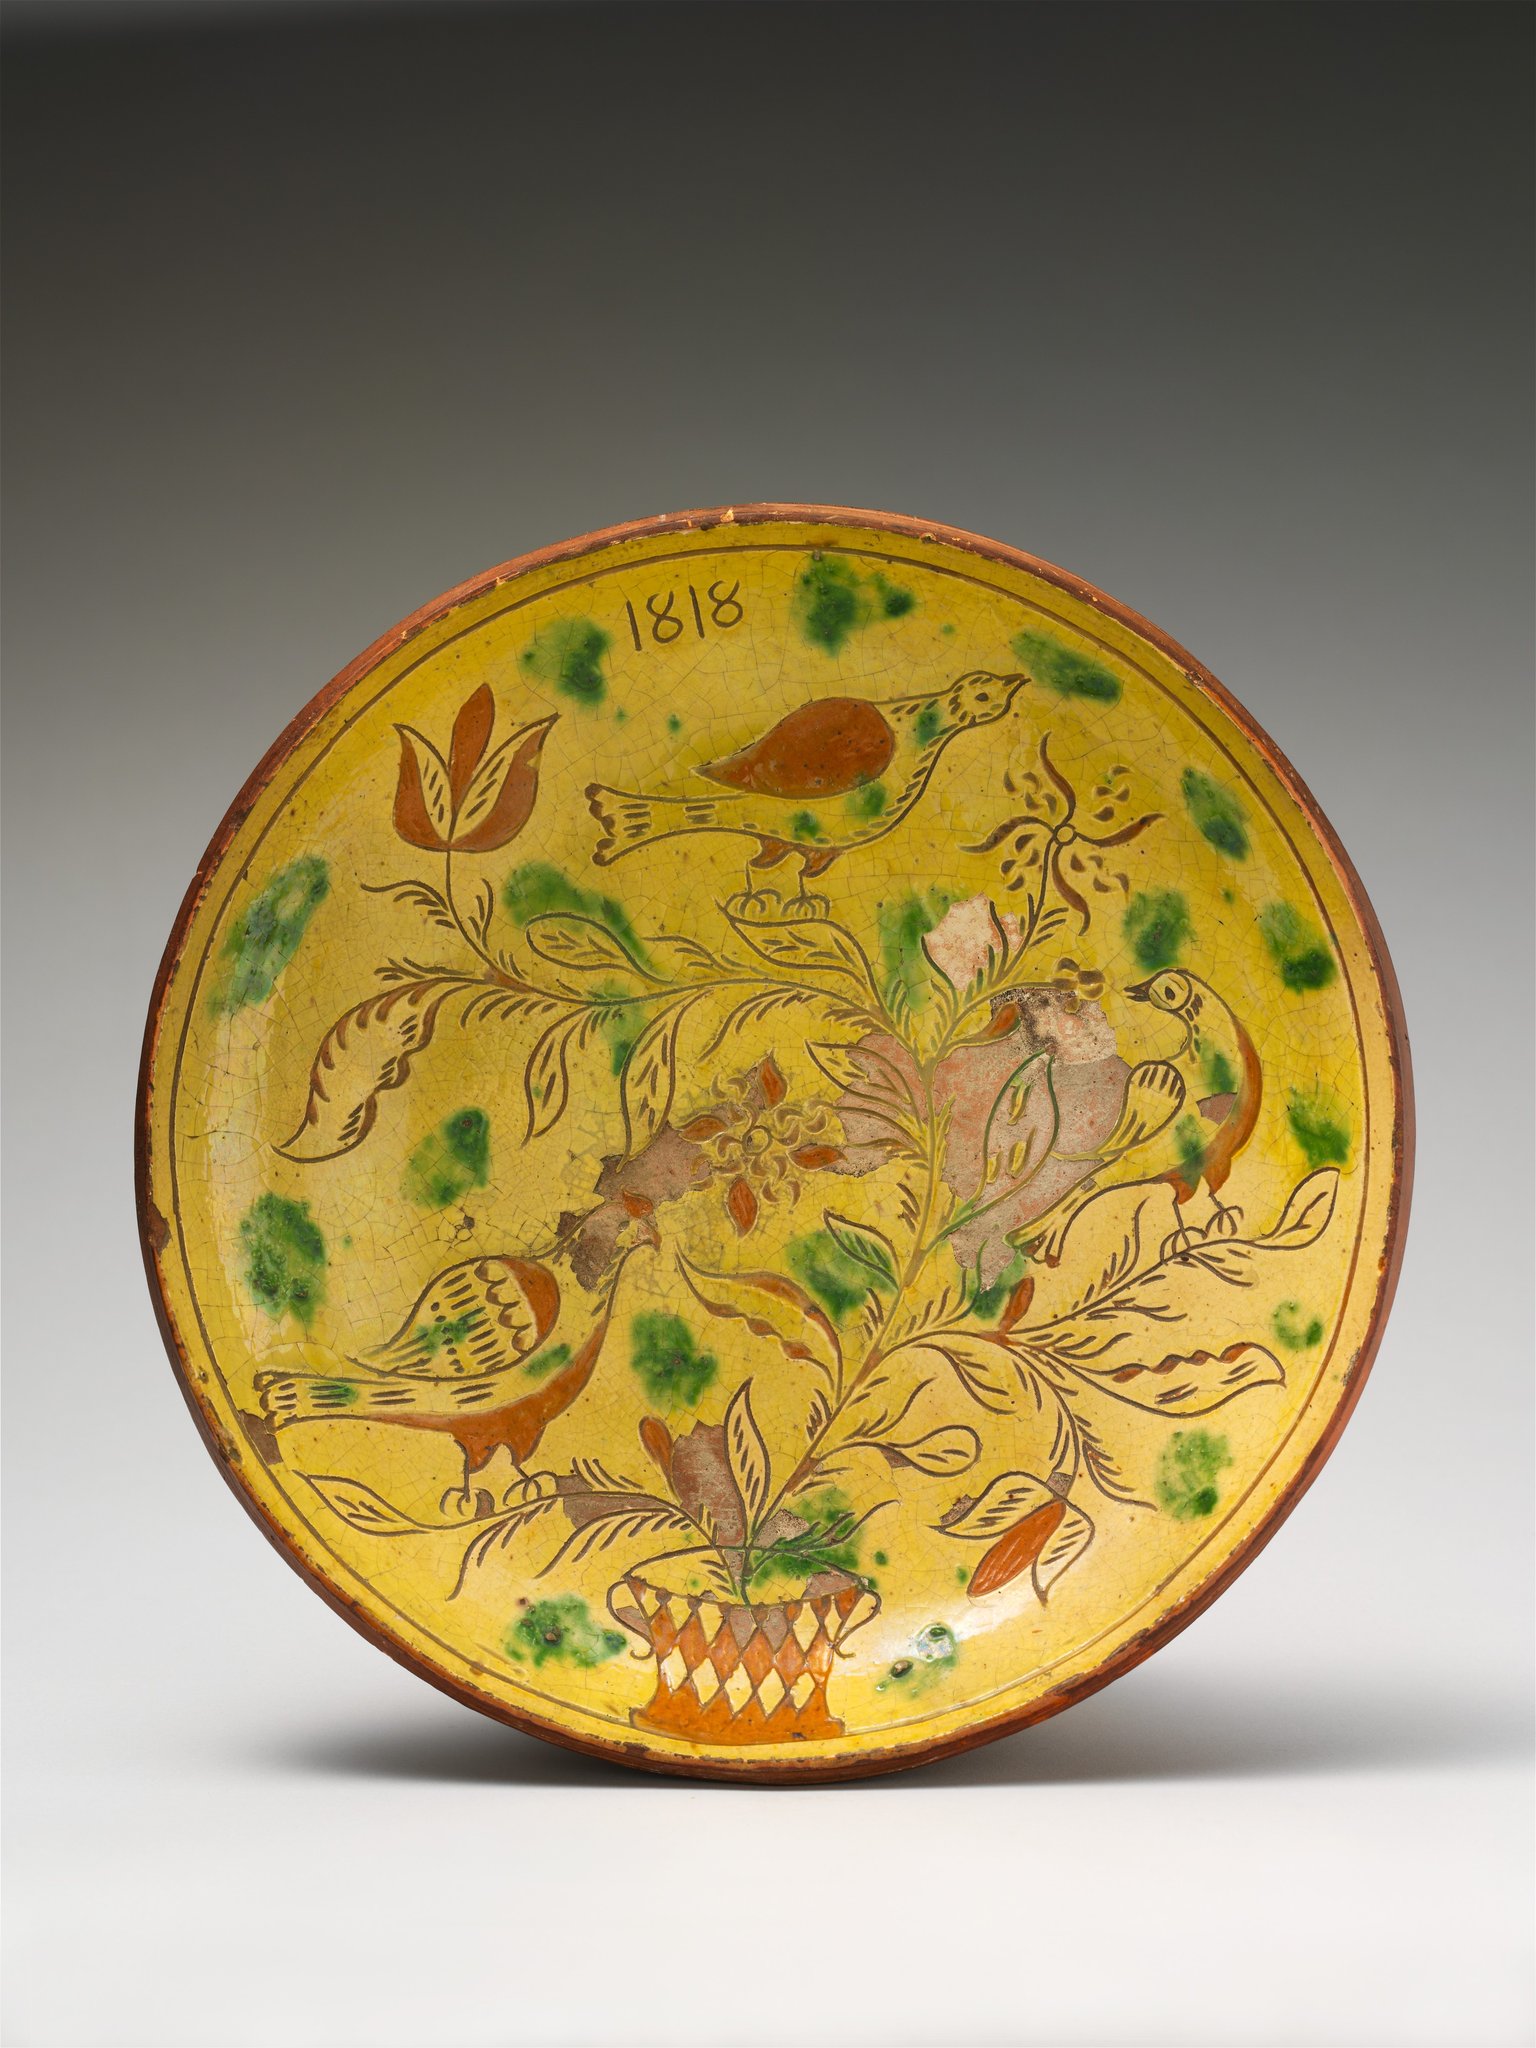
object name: plate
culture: american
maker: henry troxel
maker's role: maker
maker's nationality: american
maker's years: 1799-1829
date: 1818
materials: earthenware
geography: united states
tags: birds,flowers